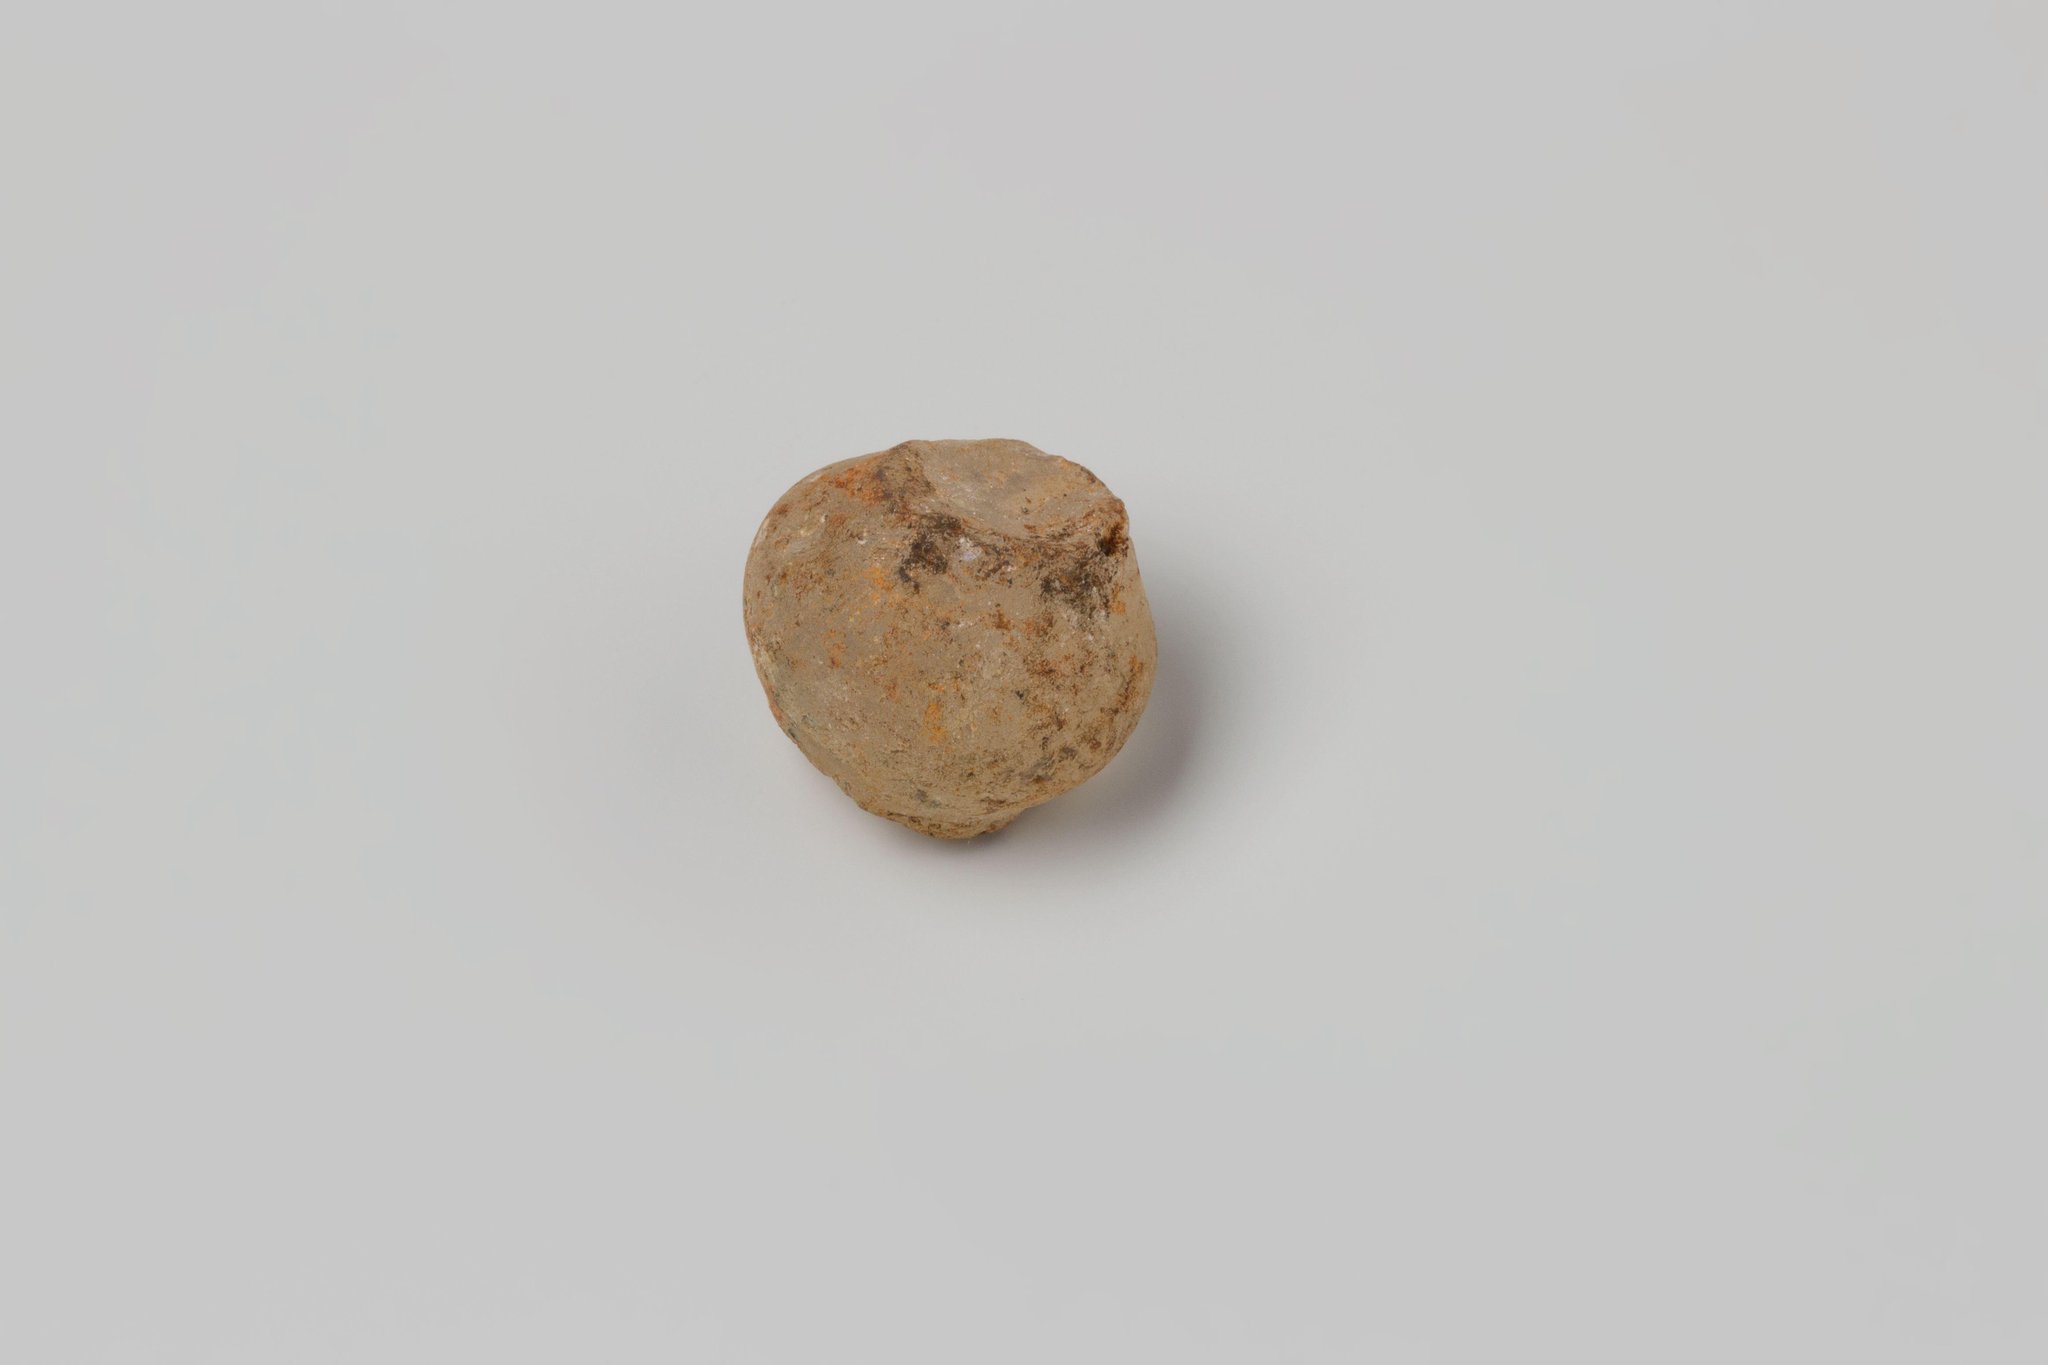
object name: flute glass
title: Fragment balustervormige steel van een fluitglas uit het wrak van de Oost-Indiëvaarder Hollandia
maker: Anonymous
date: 1700-1743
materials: glass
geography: netherlands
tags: verenigde oostindische compagnie, hollandia (schip), annet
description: Glass, stem glass, steel, baluster-shaped; fragment of knop, spherical, eroded, both ends broken off.